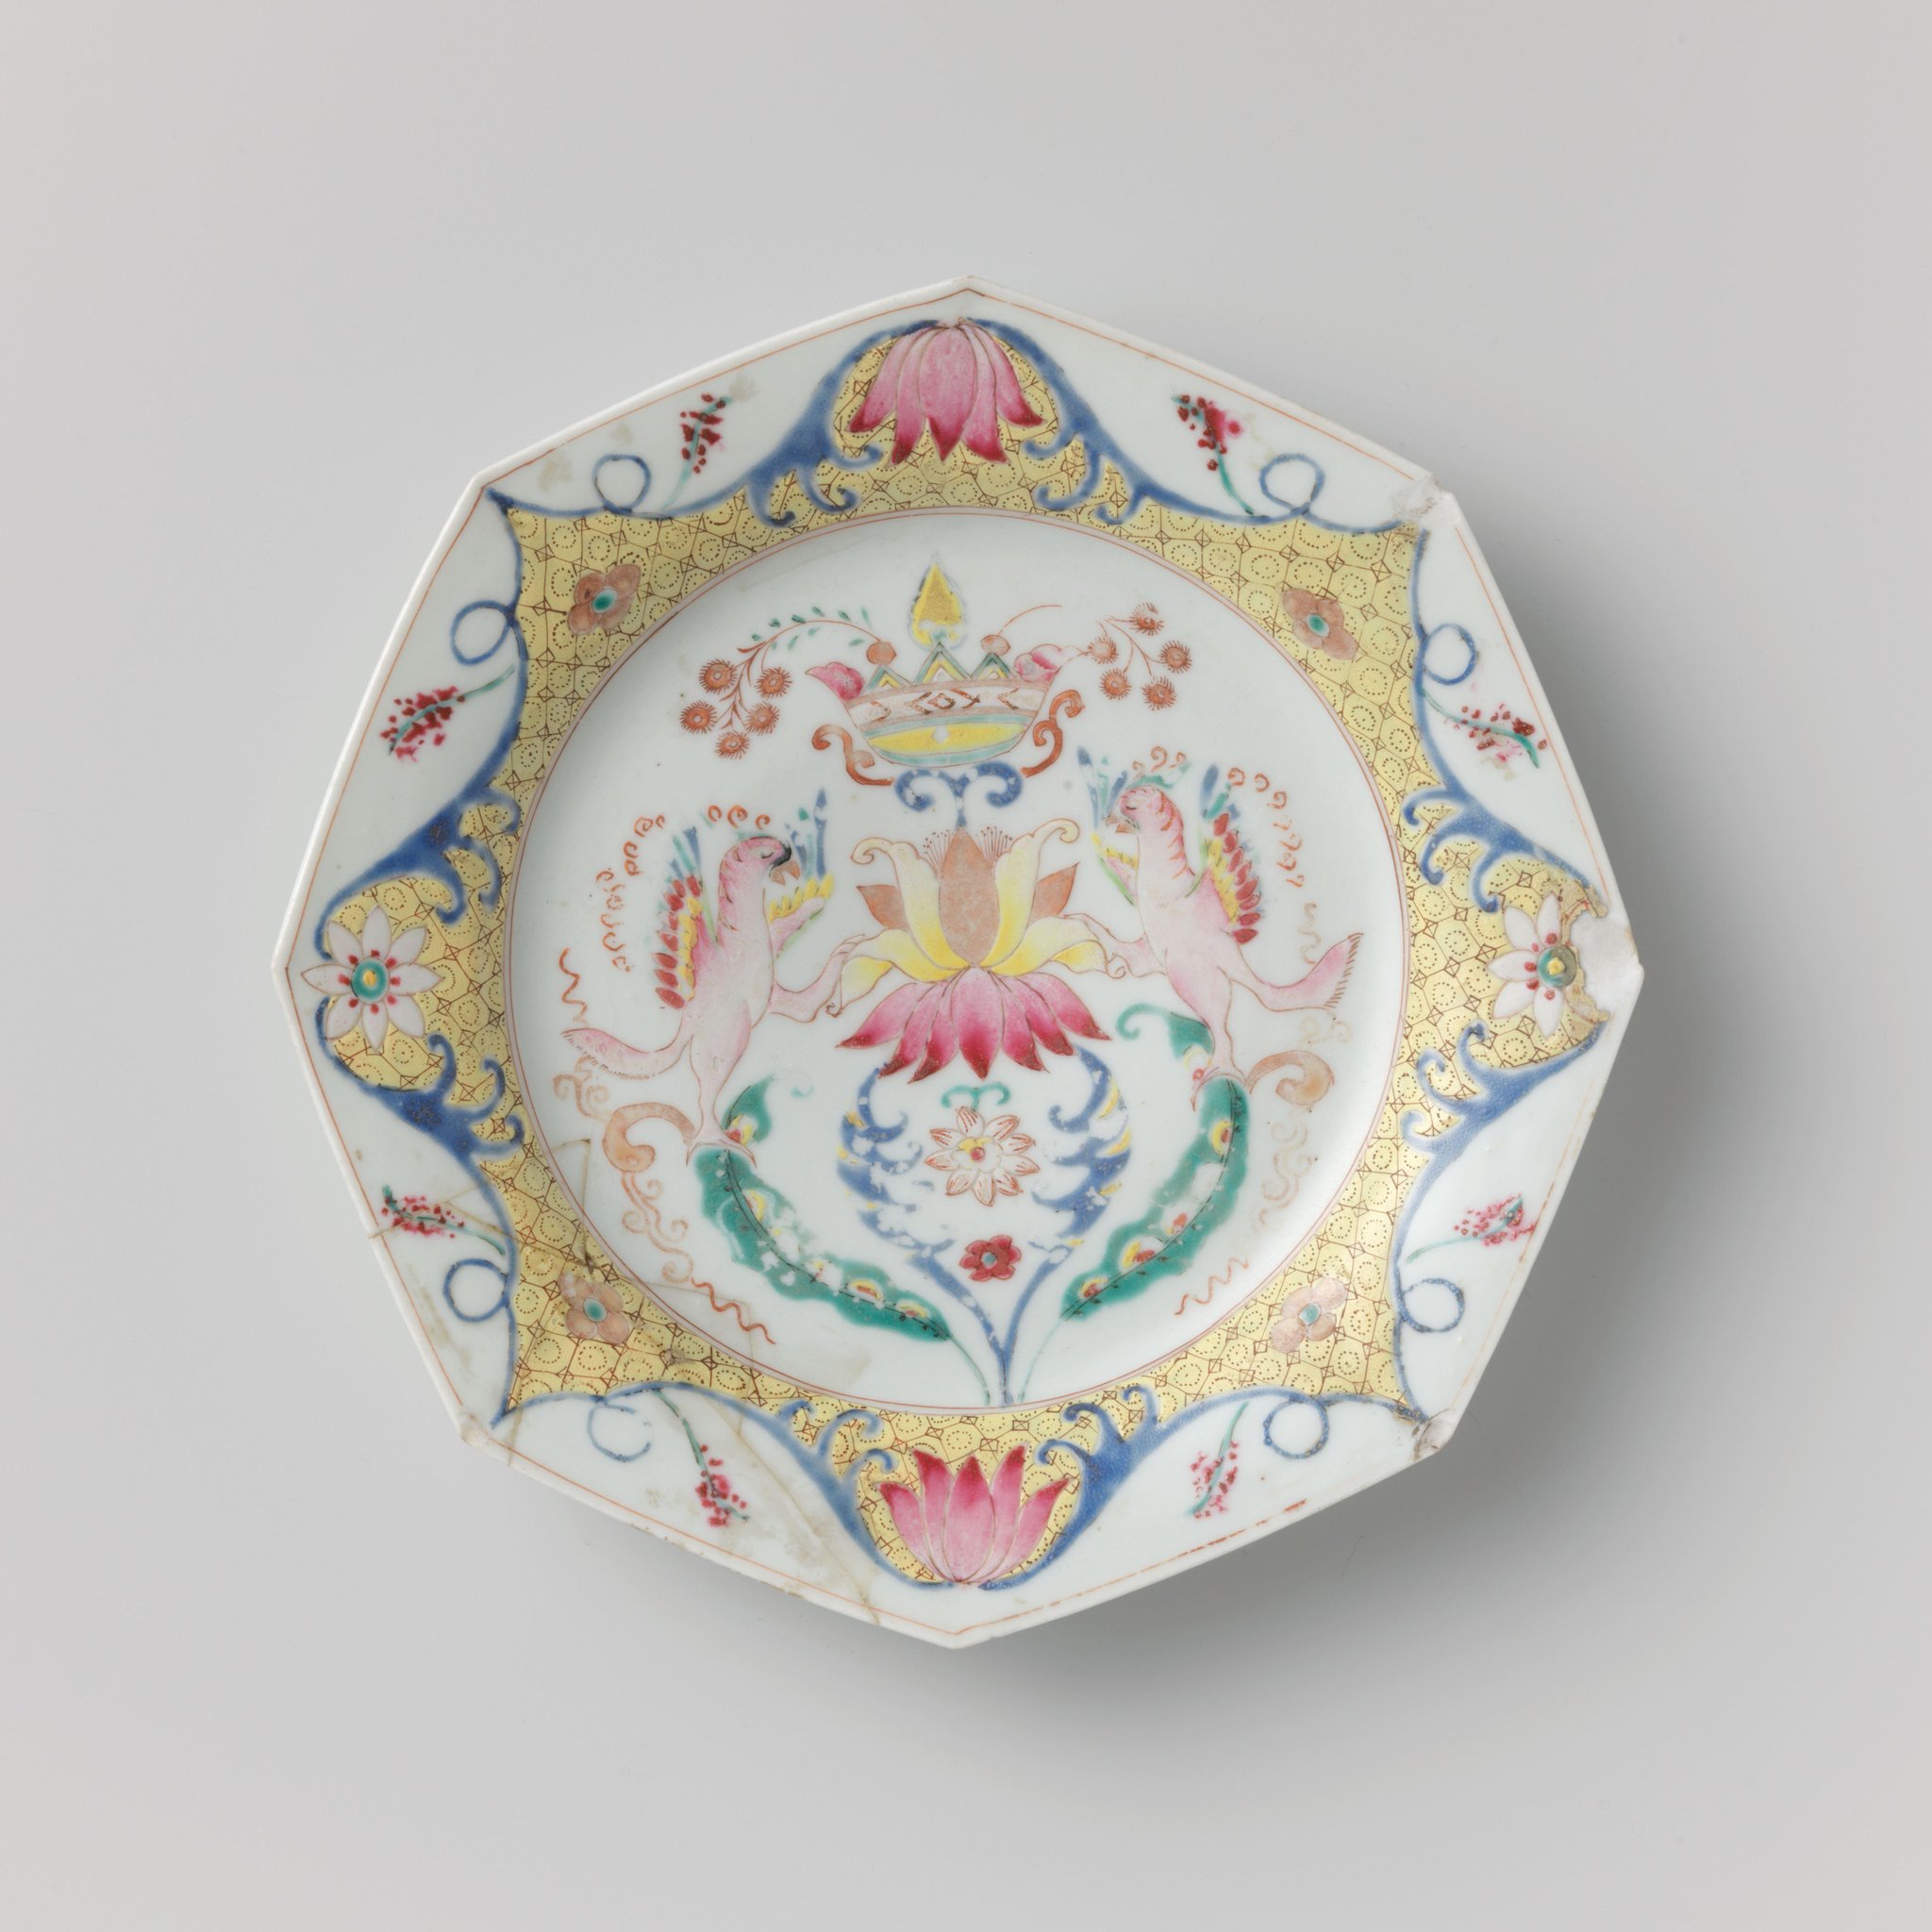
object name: plate dish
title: Octagonal plate with a crowned lotus with birds and floral scrolls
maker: Anonymous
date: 1800-1899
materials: glaze, gold, paint, porcelain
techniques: firing, forming, gilding, turning, vitrification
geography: china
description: Achtkantig bord van porselein in famille roze kleuren, met randversiering. In het plat een gekroonde lotusbloem tussen vogels.